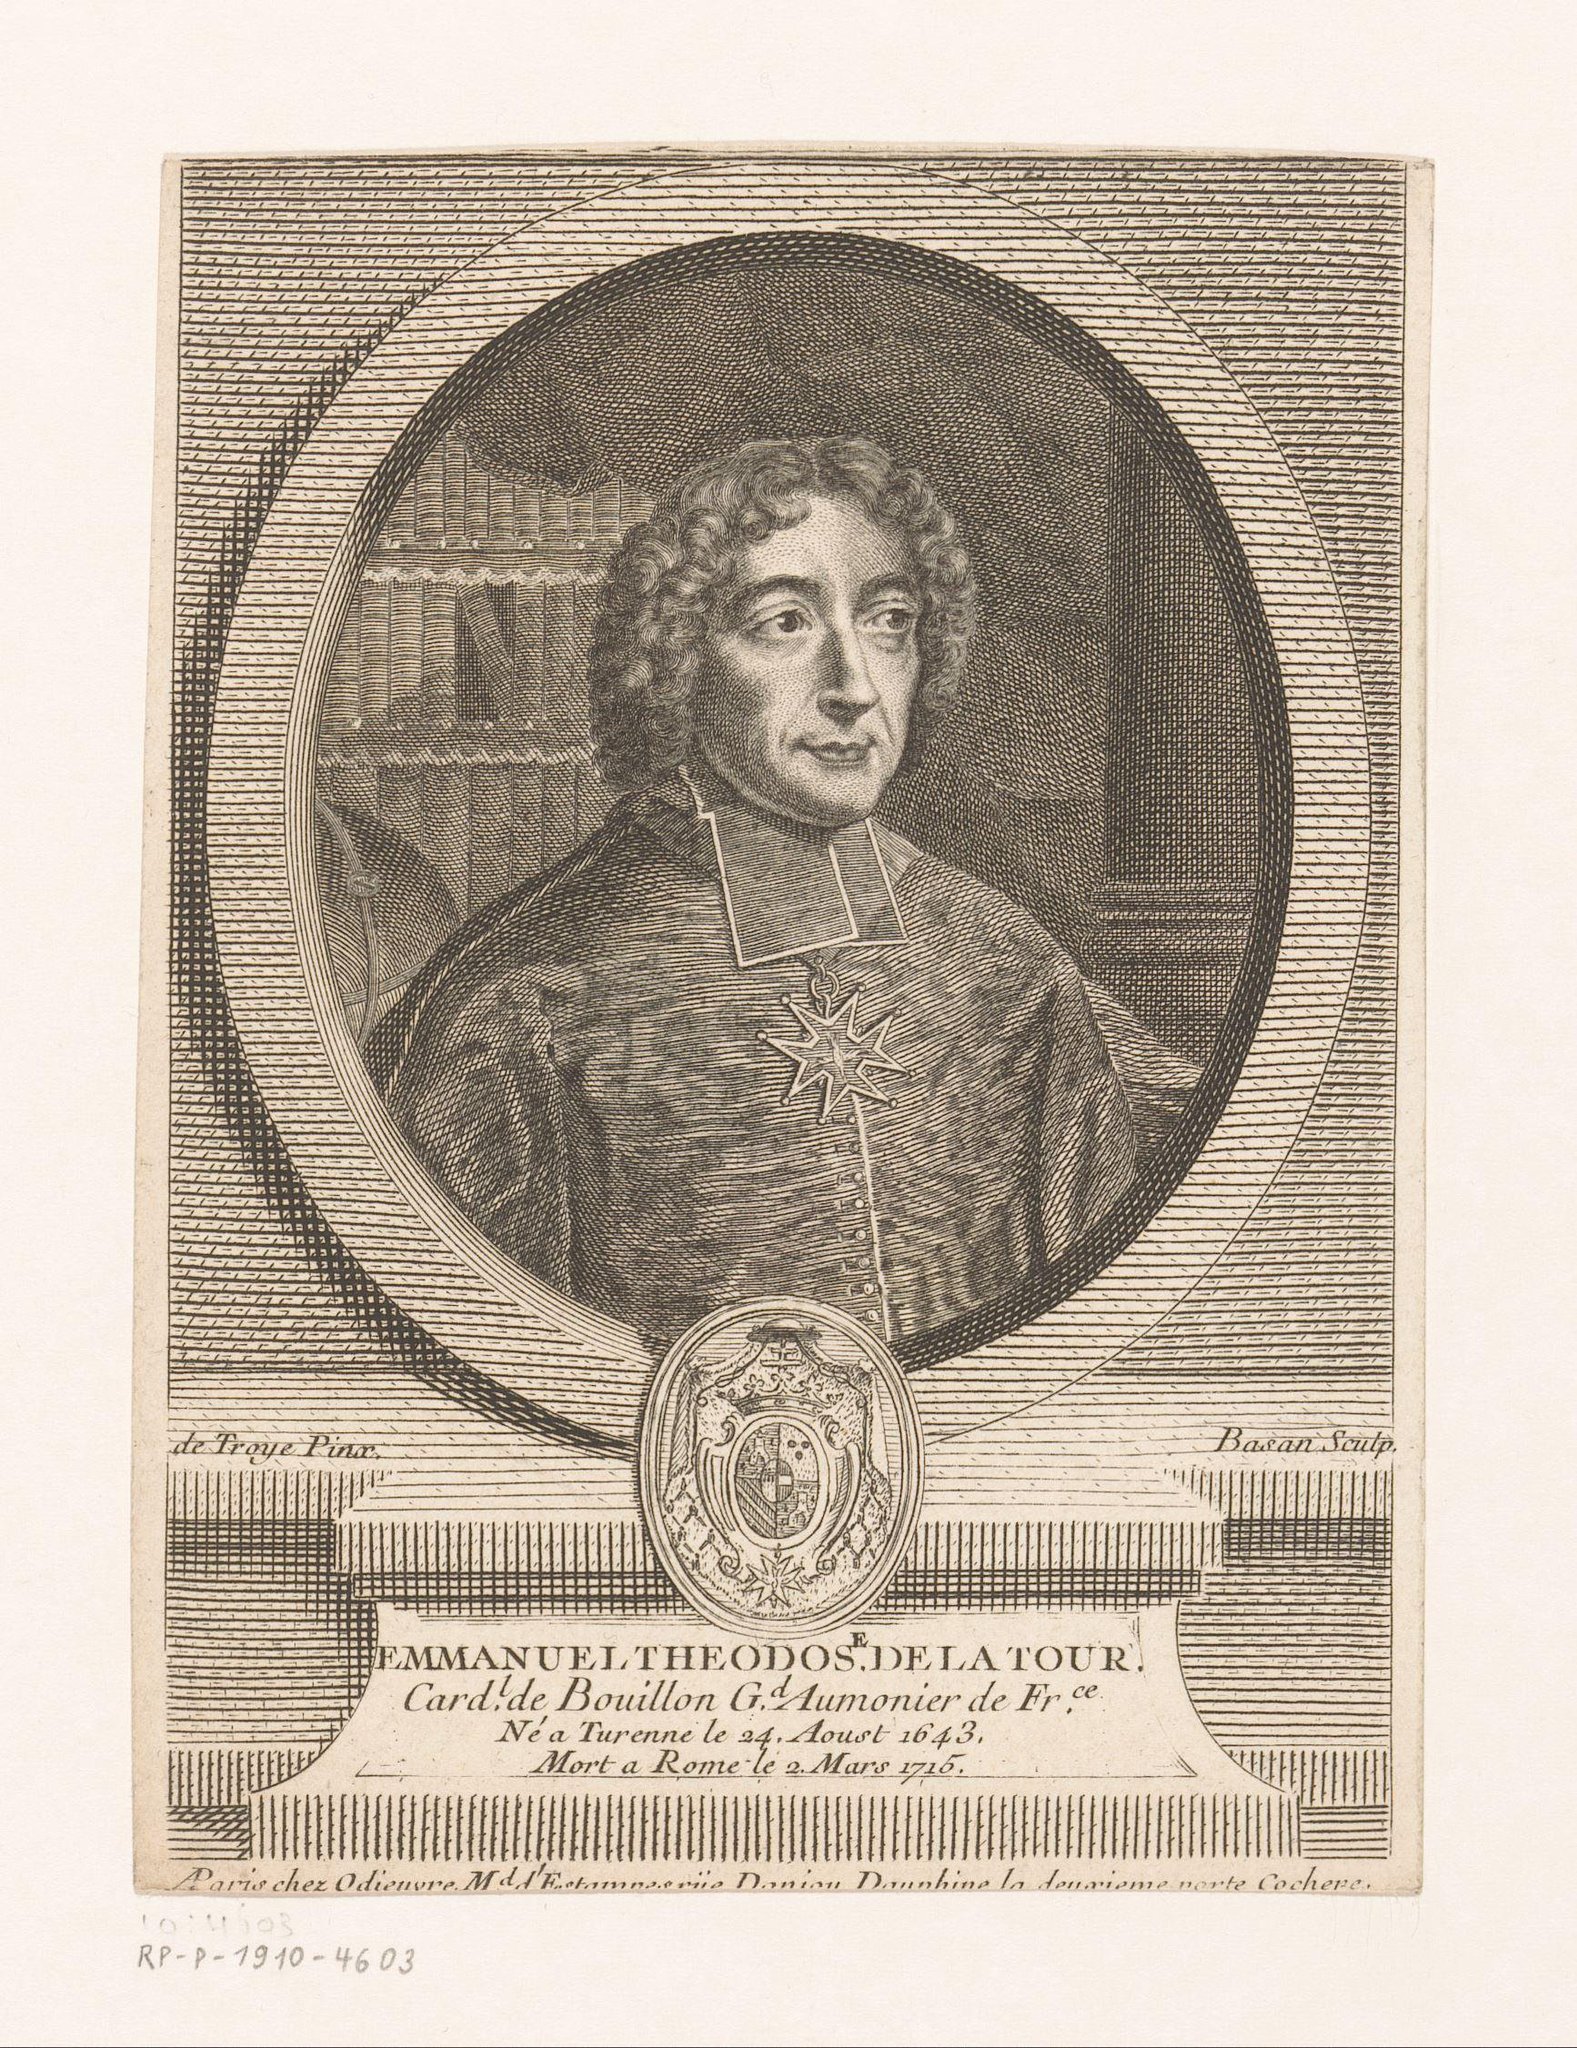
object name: print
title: Portret van Emmanuel-Théodose de La Tour d'Auvergne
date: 1733-1756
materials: paper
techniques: engraving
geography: paris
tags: emanuel theodius de la tour d'auvergne hertog van bouillon, ornament ~ medallion, historical persons, armorial bearing, heraldry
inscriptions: collector's mark: Lugt 2228